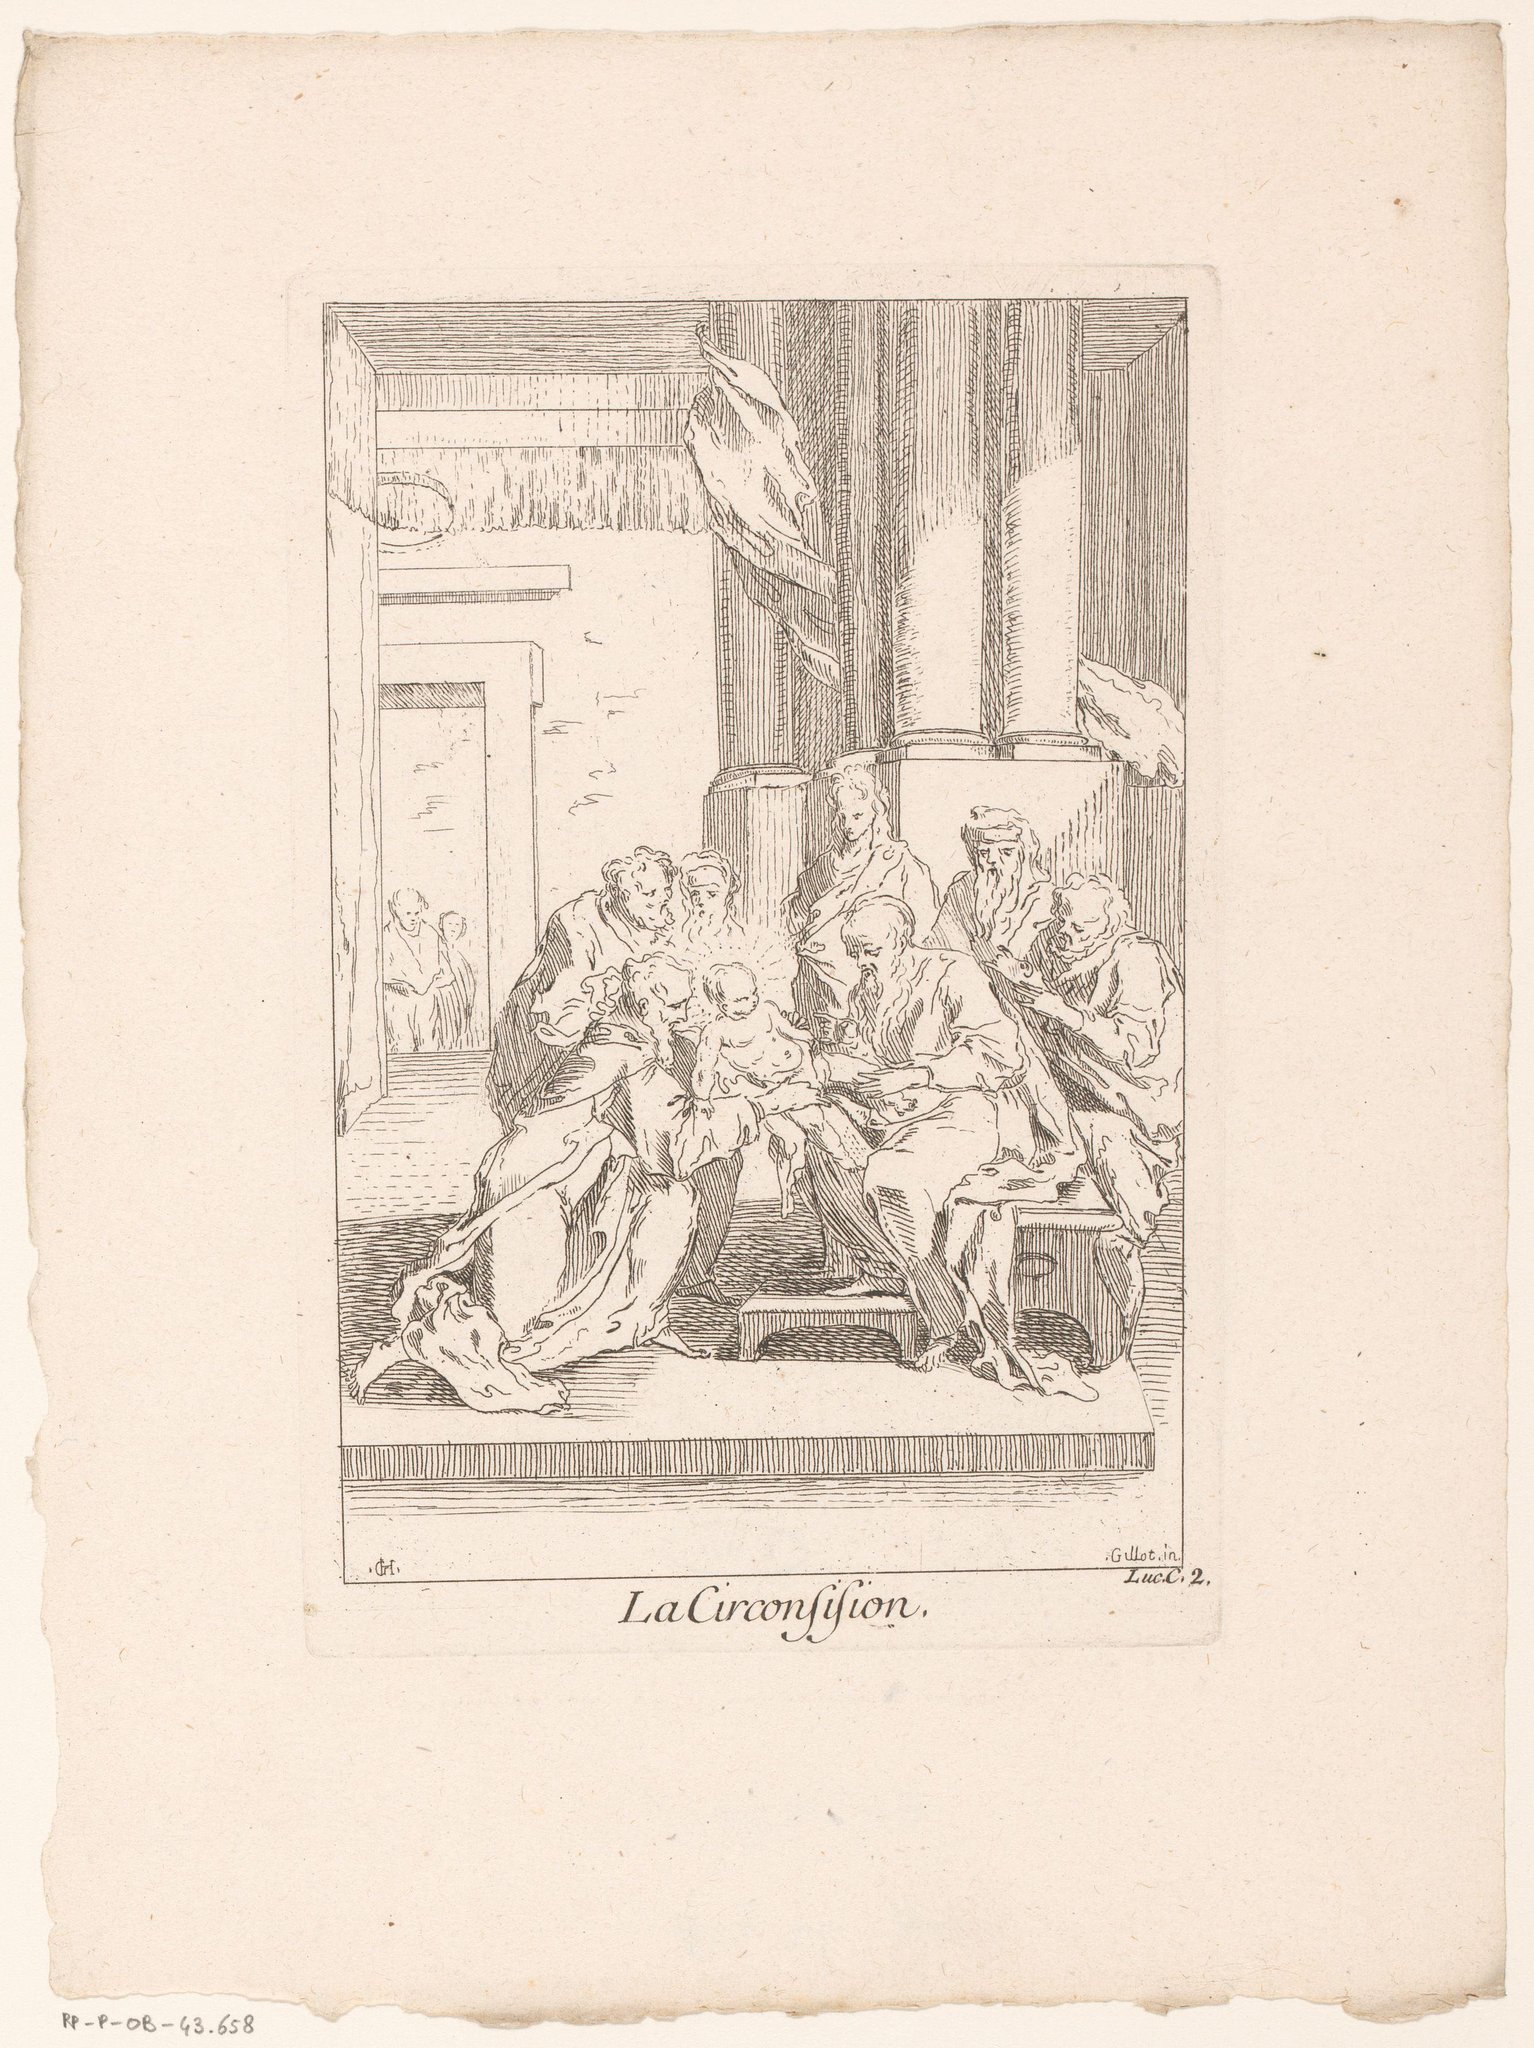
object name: print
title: Leven en passie van Christus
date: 1705-1732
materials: paper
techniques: etching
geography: france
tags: circumcision of the christ-child by the priest in the temple (luke 2:21)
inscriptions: collector's mark: Lugt 2228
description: Maakt deel uit van een serie met zestig prenten met als thema het leven van Christus.